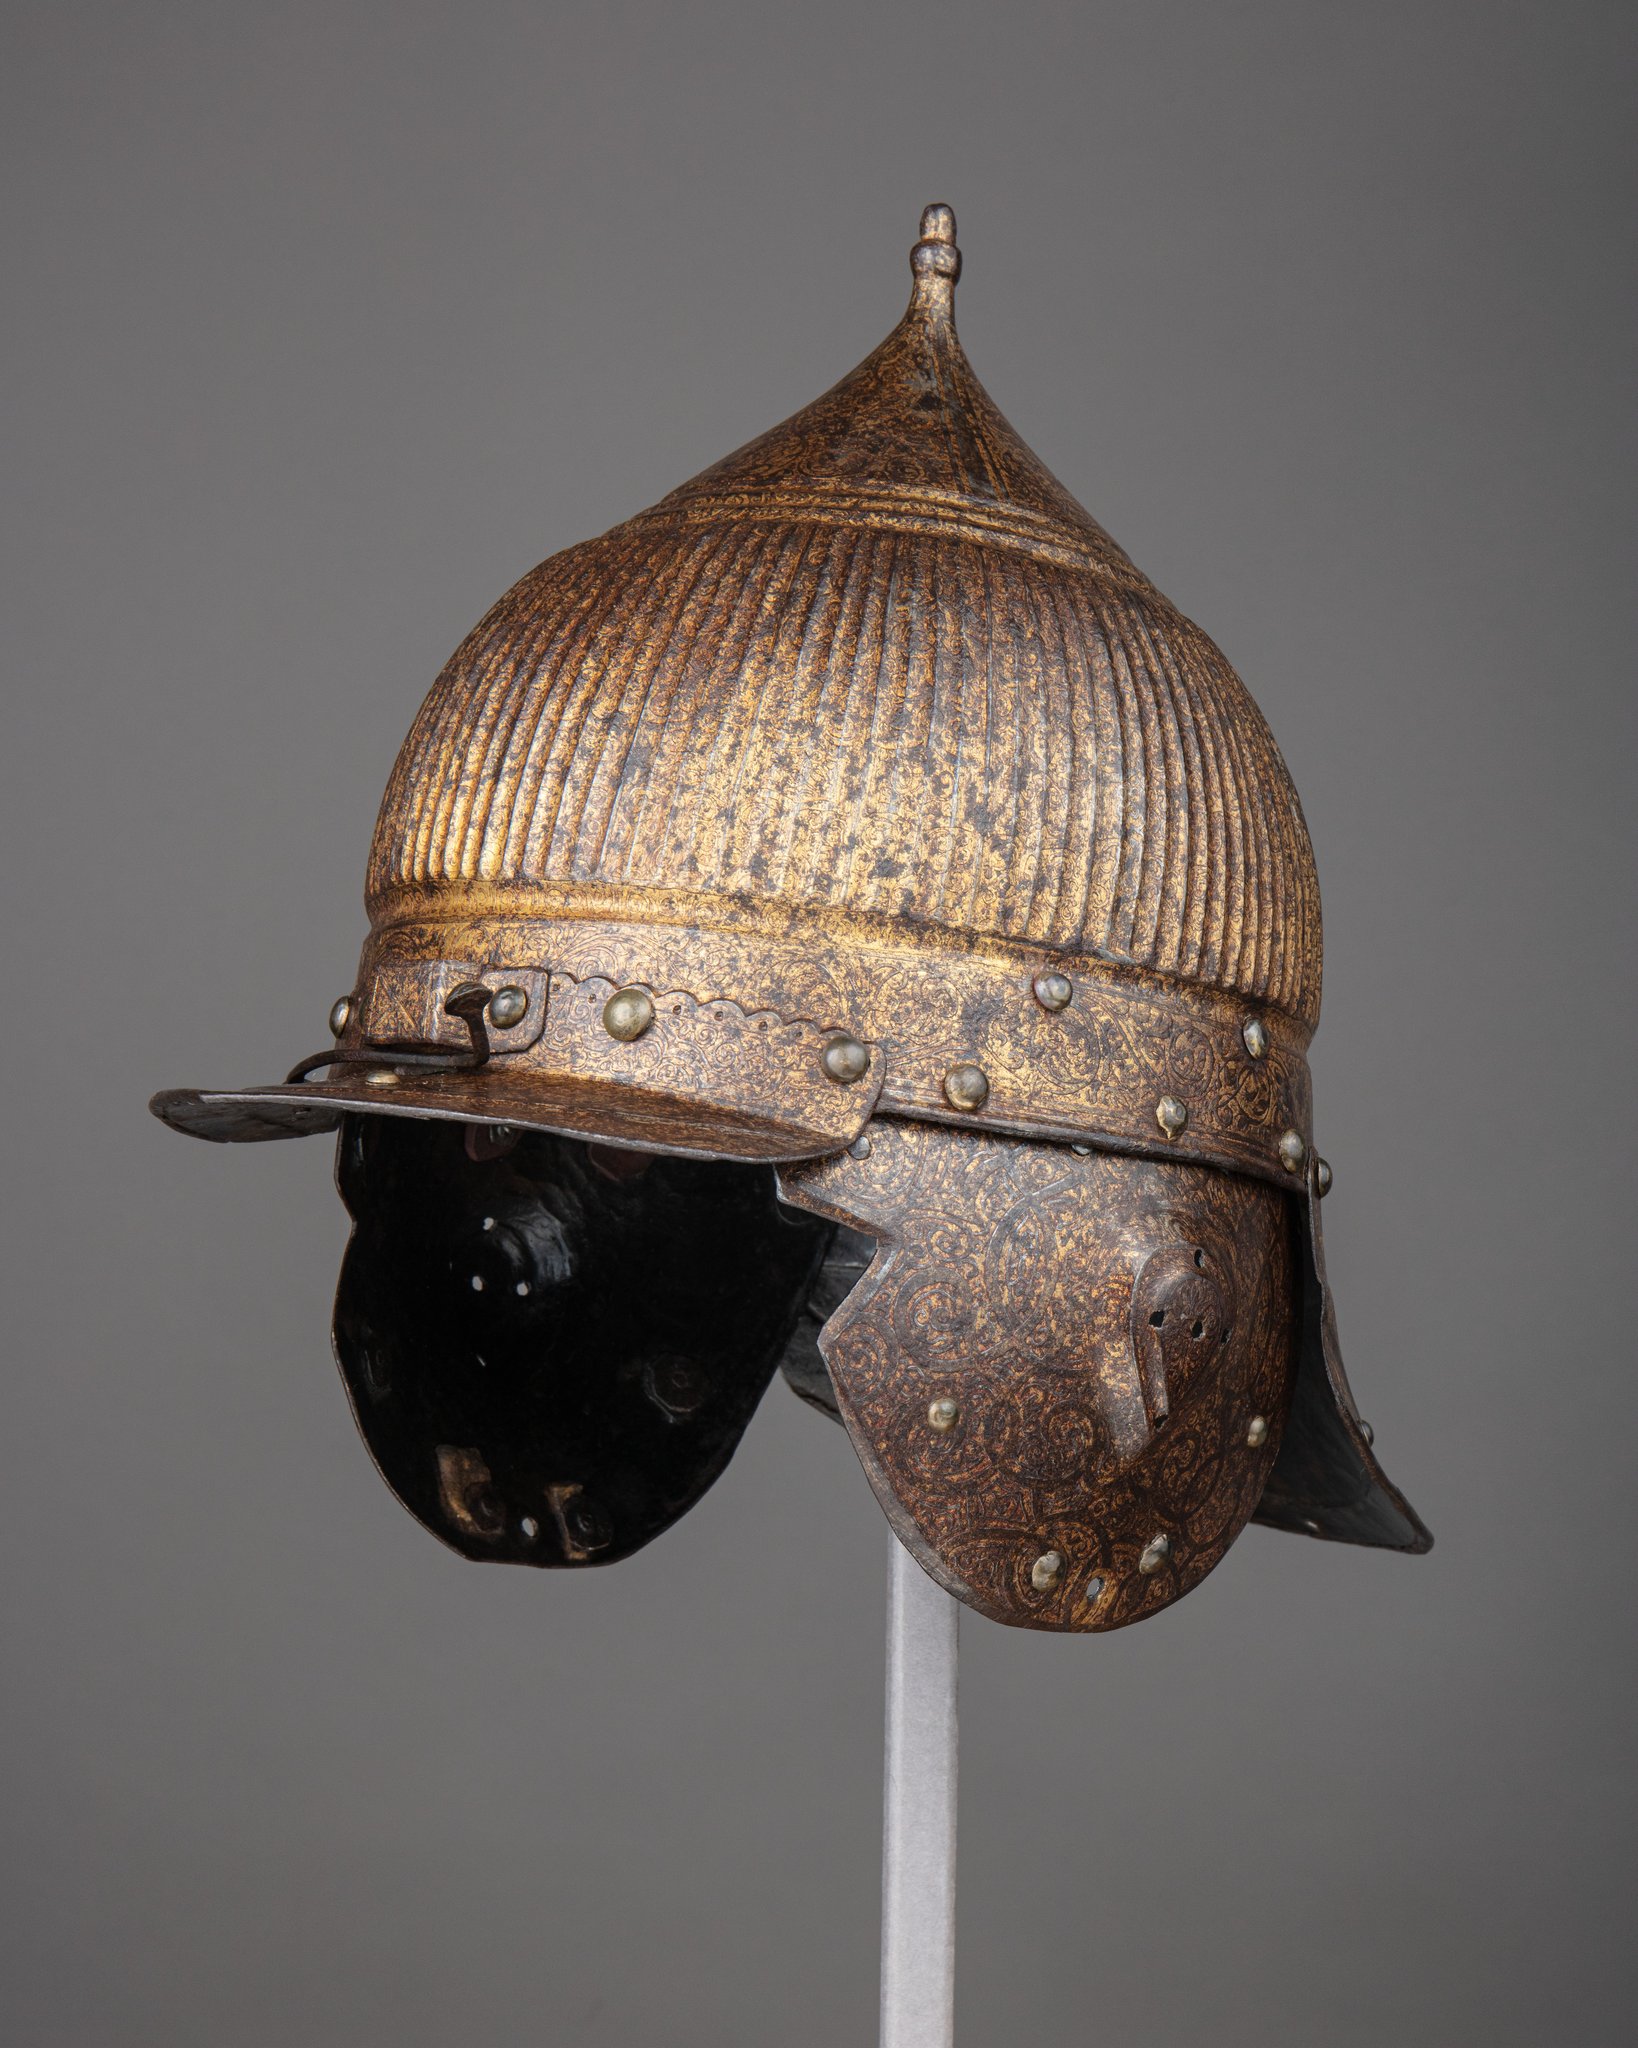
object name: burgonet zischägge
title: Burgonet (Zischägge)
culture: german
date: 1560-1570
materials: copper alloy, gold, leather, steel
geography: germany